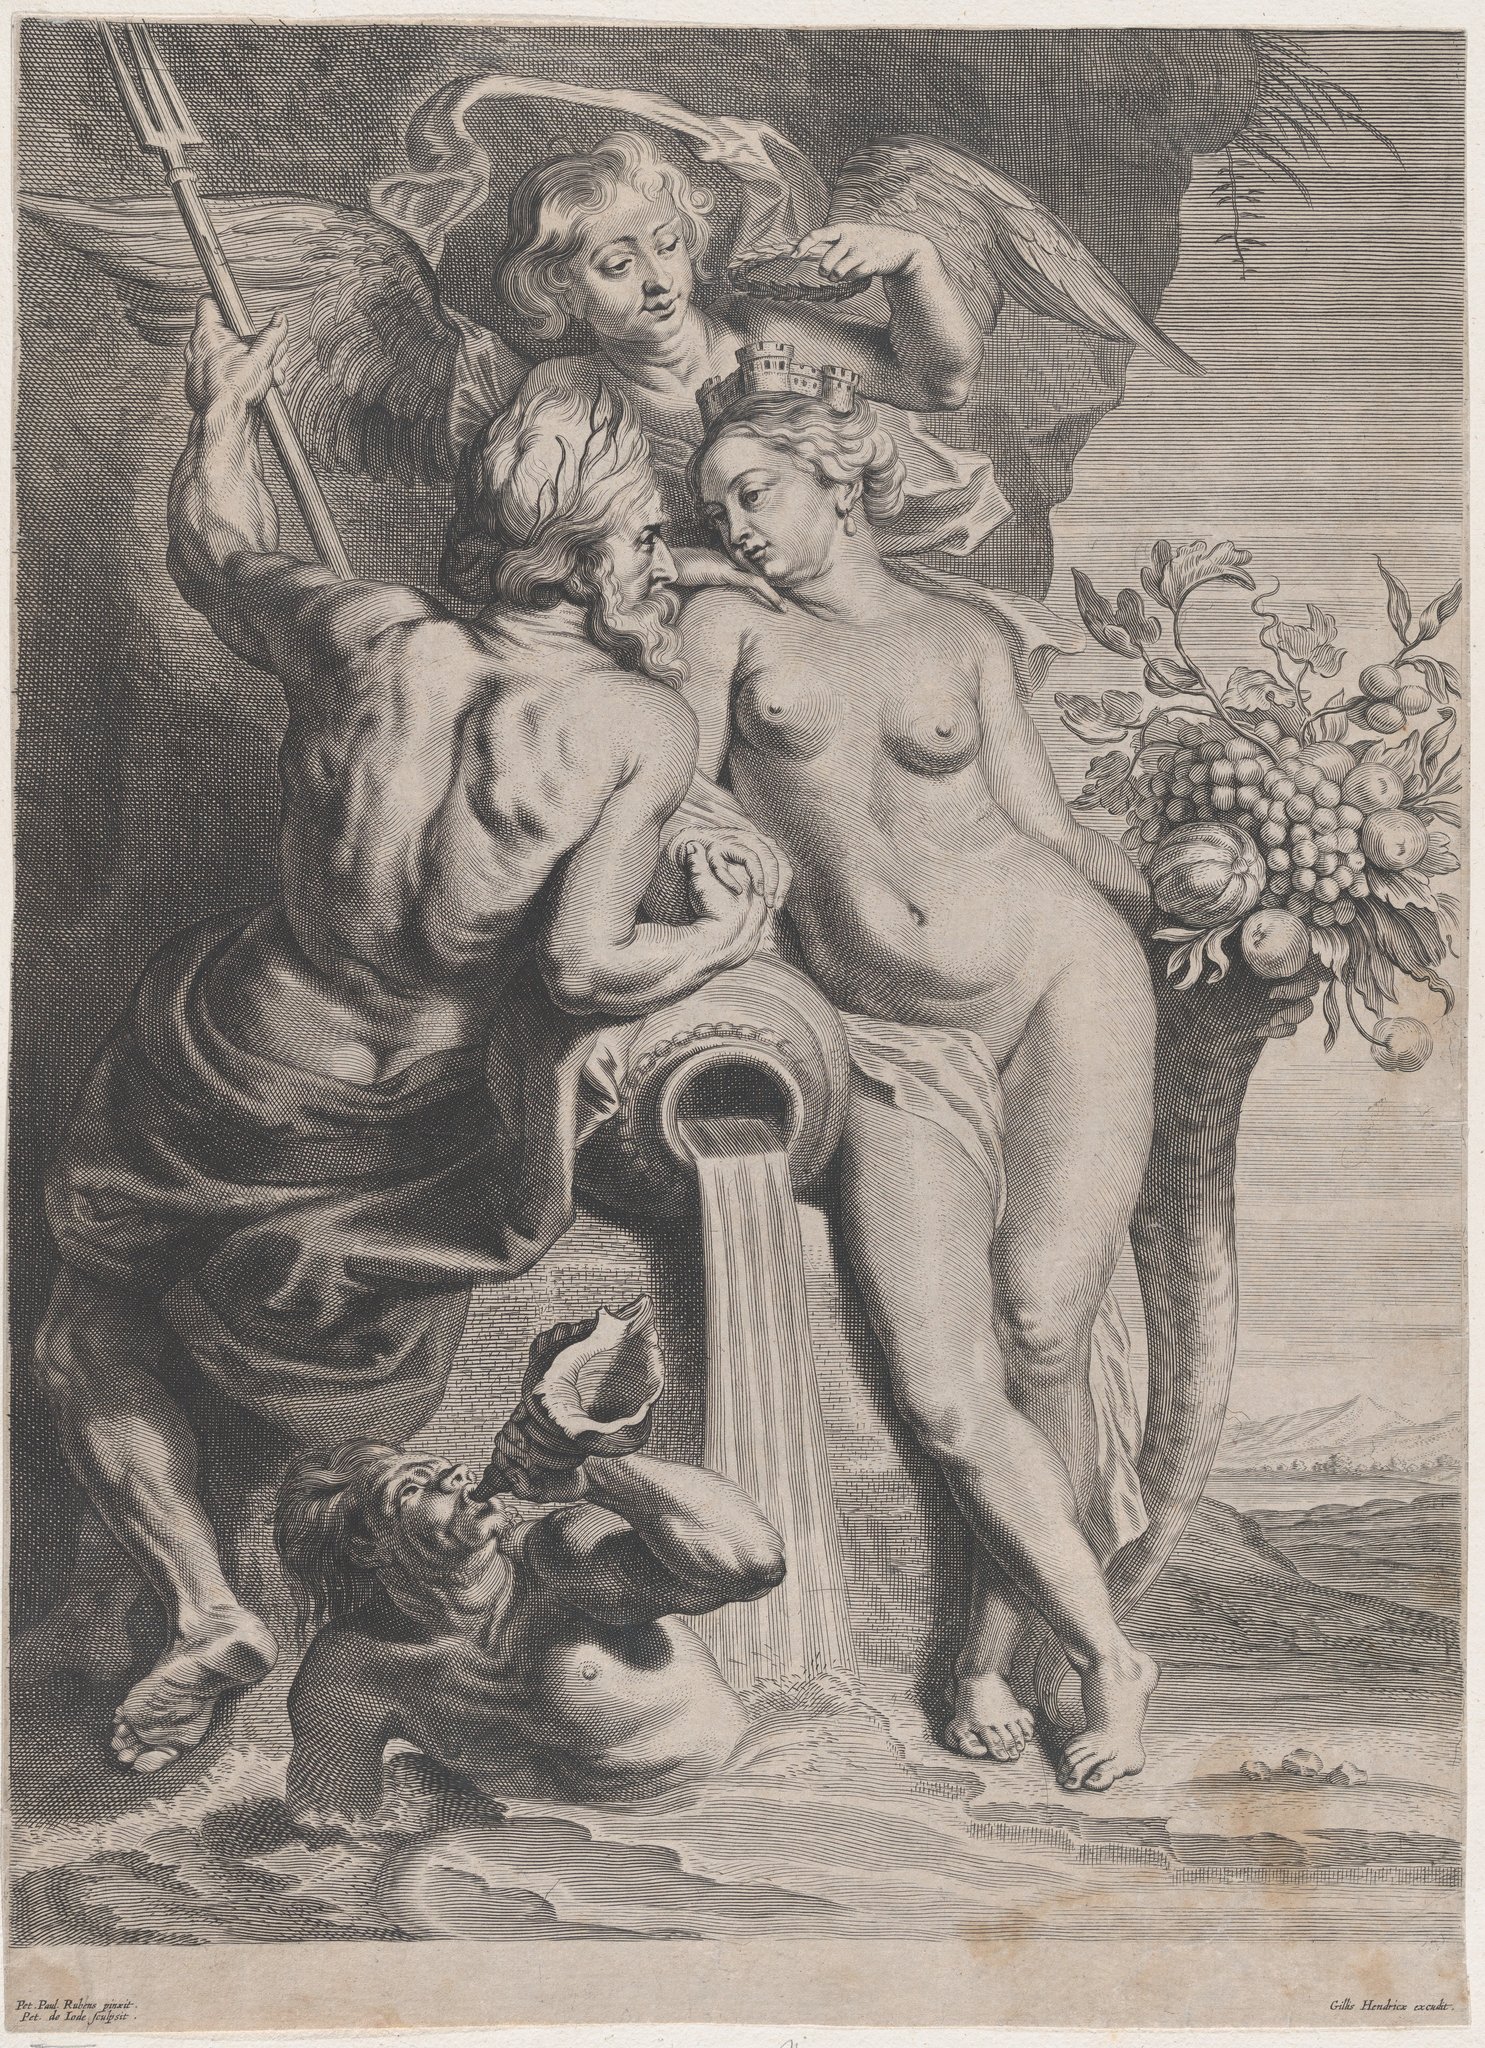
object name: print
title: Neptune and Cybele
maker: pieter de jode (ii)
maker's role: artist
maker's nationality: flemish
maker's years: 1606-1674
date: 1640-1674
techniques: engraving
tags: neptune,goddess